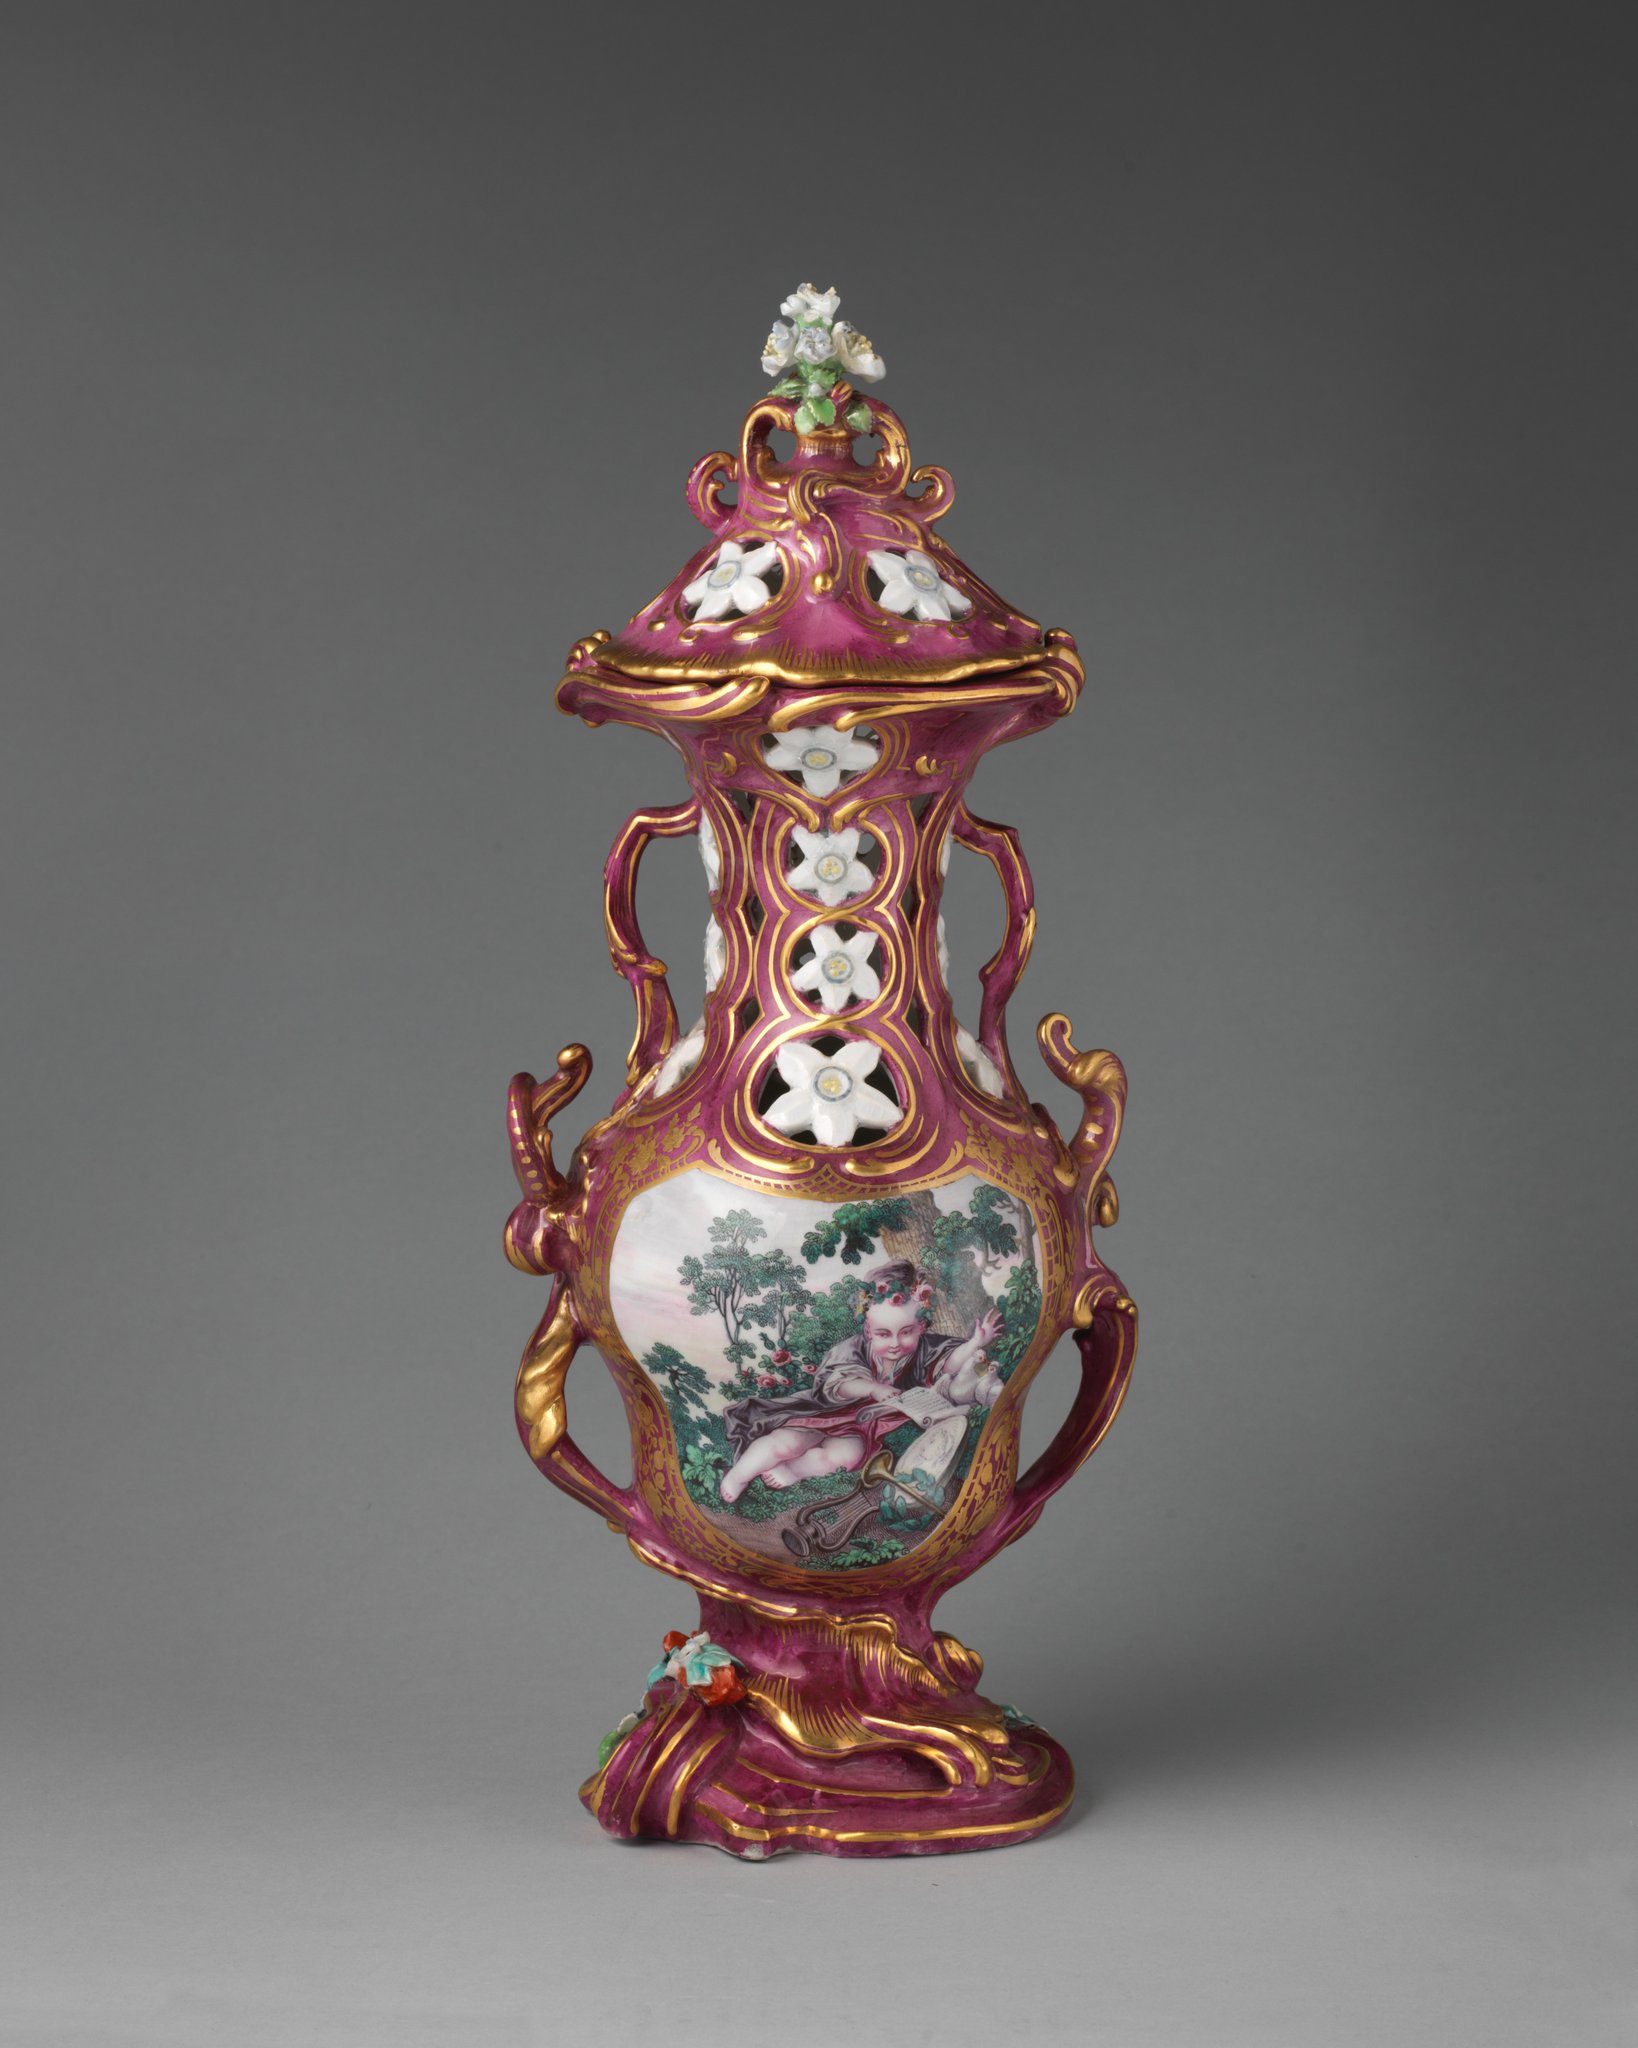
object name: vase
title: Vase (one of a set of three)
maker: chelsea porcelain manufactory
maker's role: factory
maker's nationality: british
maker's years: 1744-1784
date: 1761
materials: soft paste porcelain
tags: chickens,children,flowers